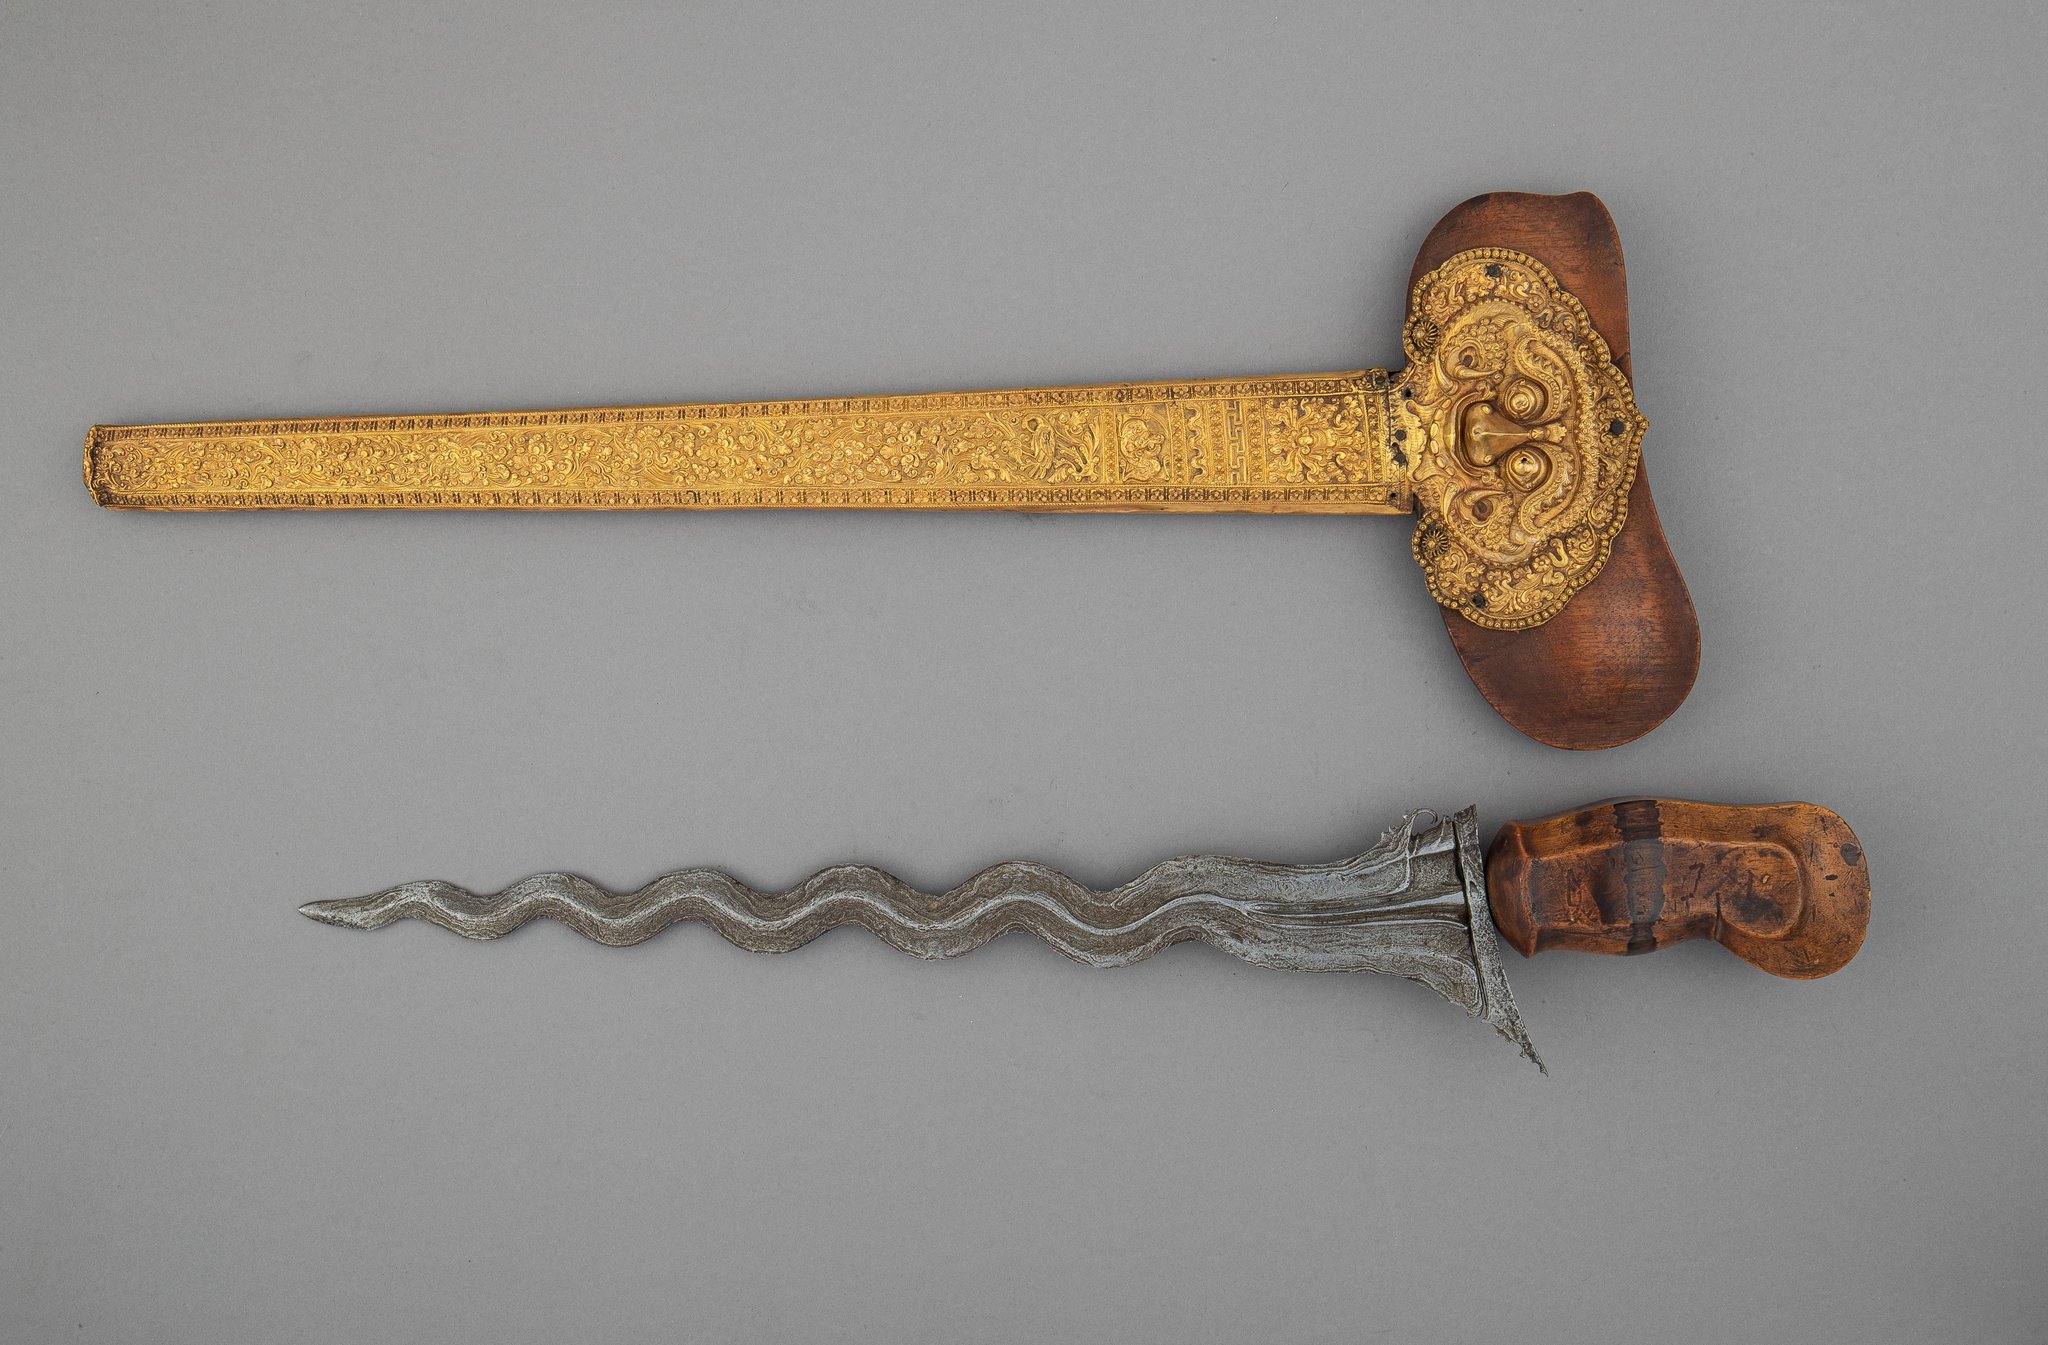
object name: kris with sheath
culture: balinese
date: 1501-1900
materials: brass, steel, wood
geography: indonesia